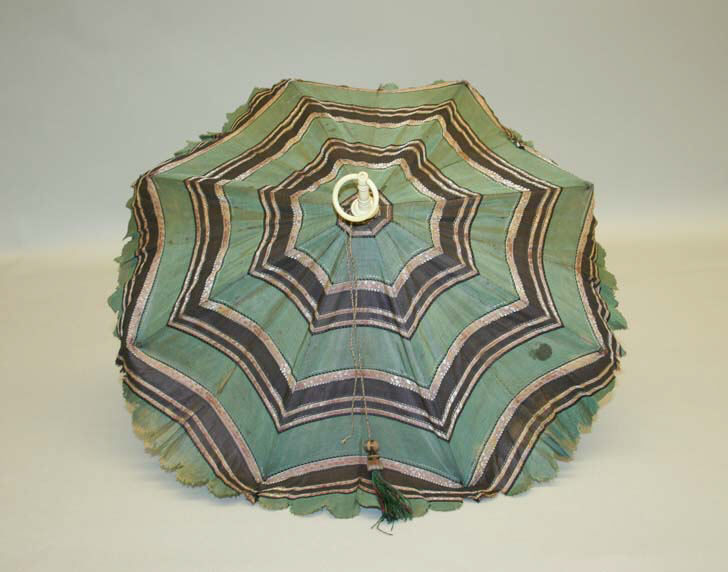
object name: parasol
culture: american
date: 1834-1866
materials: silk, wool